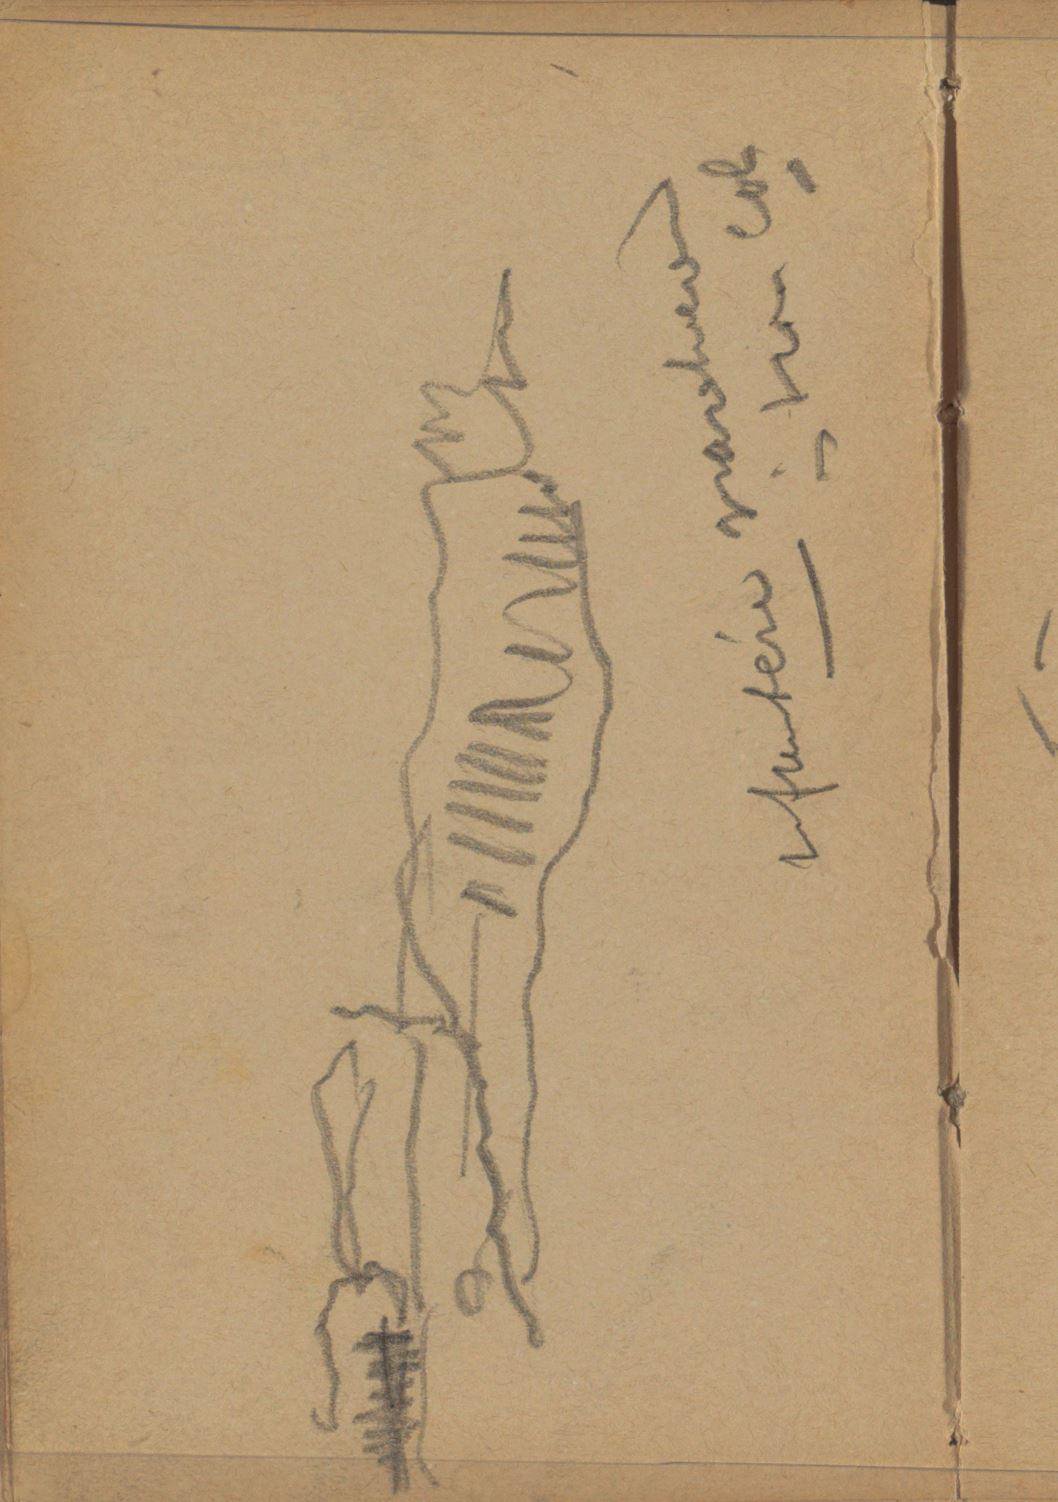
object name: sketchbook leaf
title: Landschap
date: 1887-1891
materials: paper, pencil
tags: landscapes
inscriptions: annotation: ‘infanterie [...]’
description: Pagina 27 uit een schetsboek met 83 bladen.